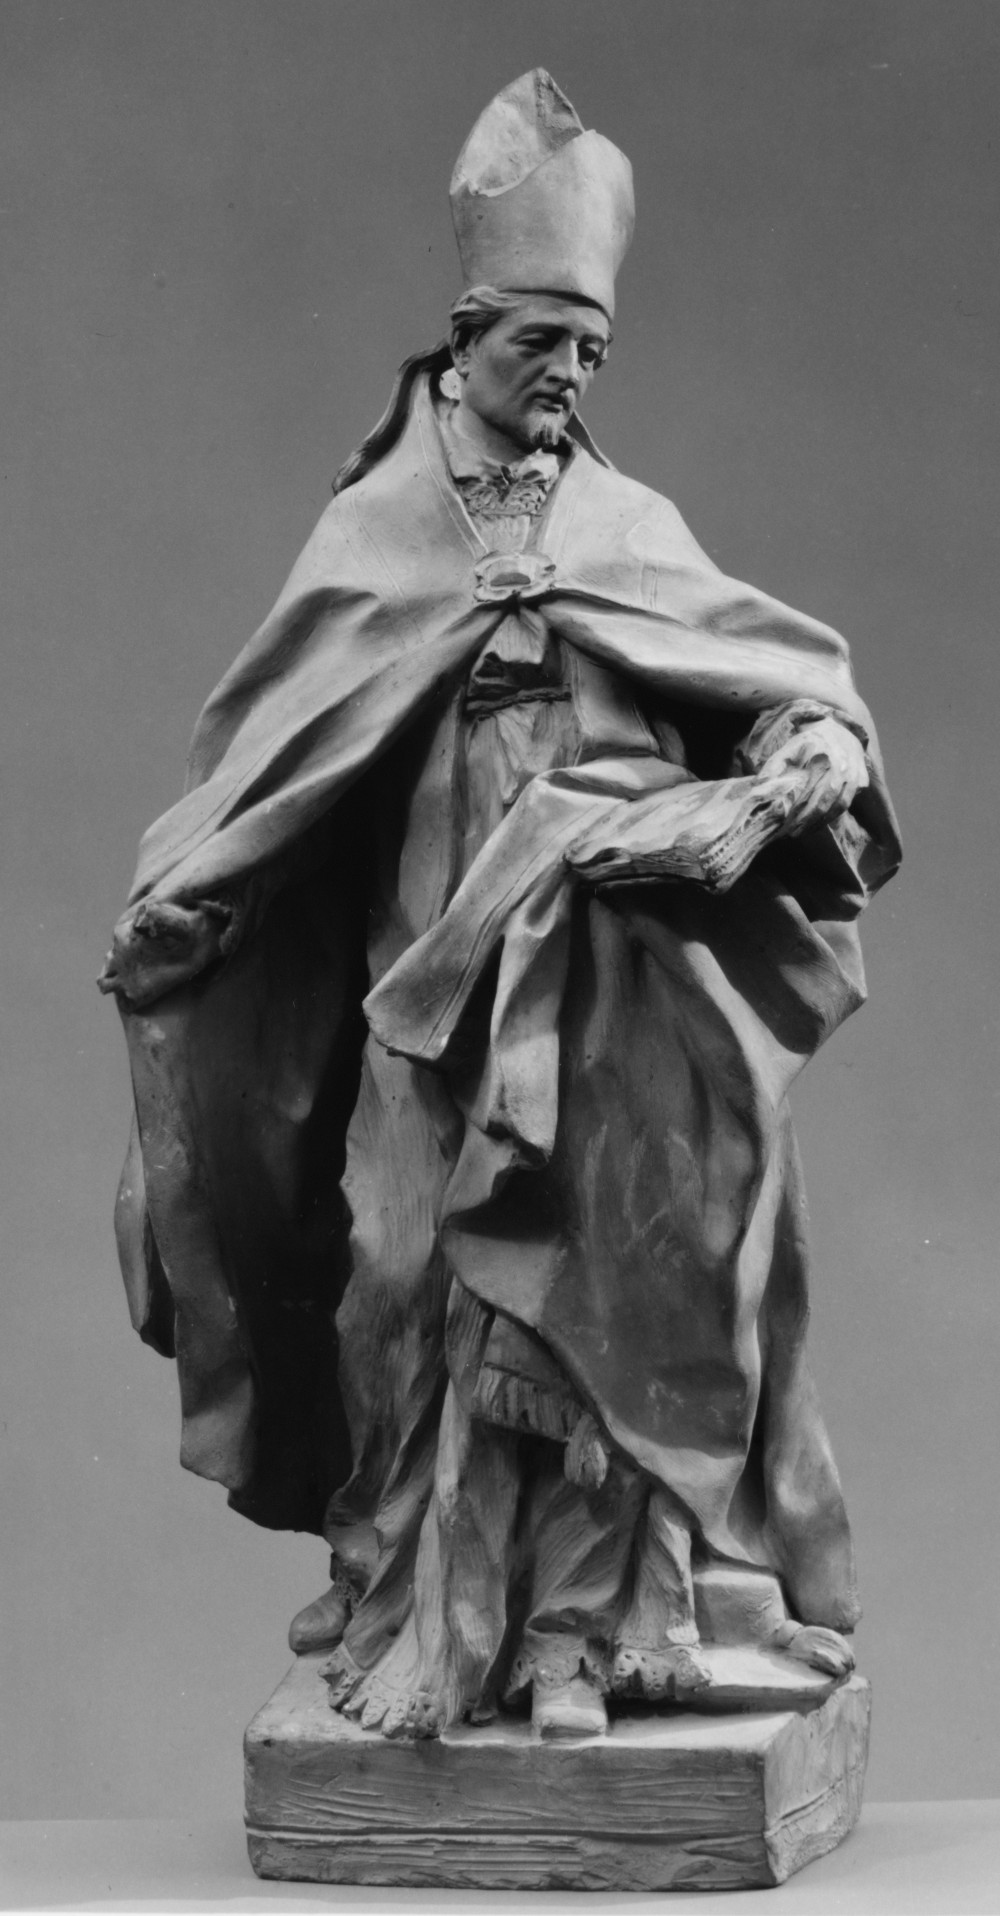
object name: statuette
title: Bishop Saint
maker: pierre legros ii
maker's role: artist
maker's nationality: italian, born france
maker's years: 1666-1719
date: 1667-1733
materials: terracotta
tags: bishops,saints